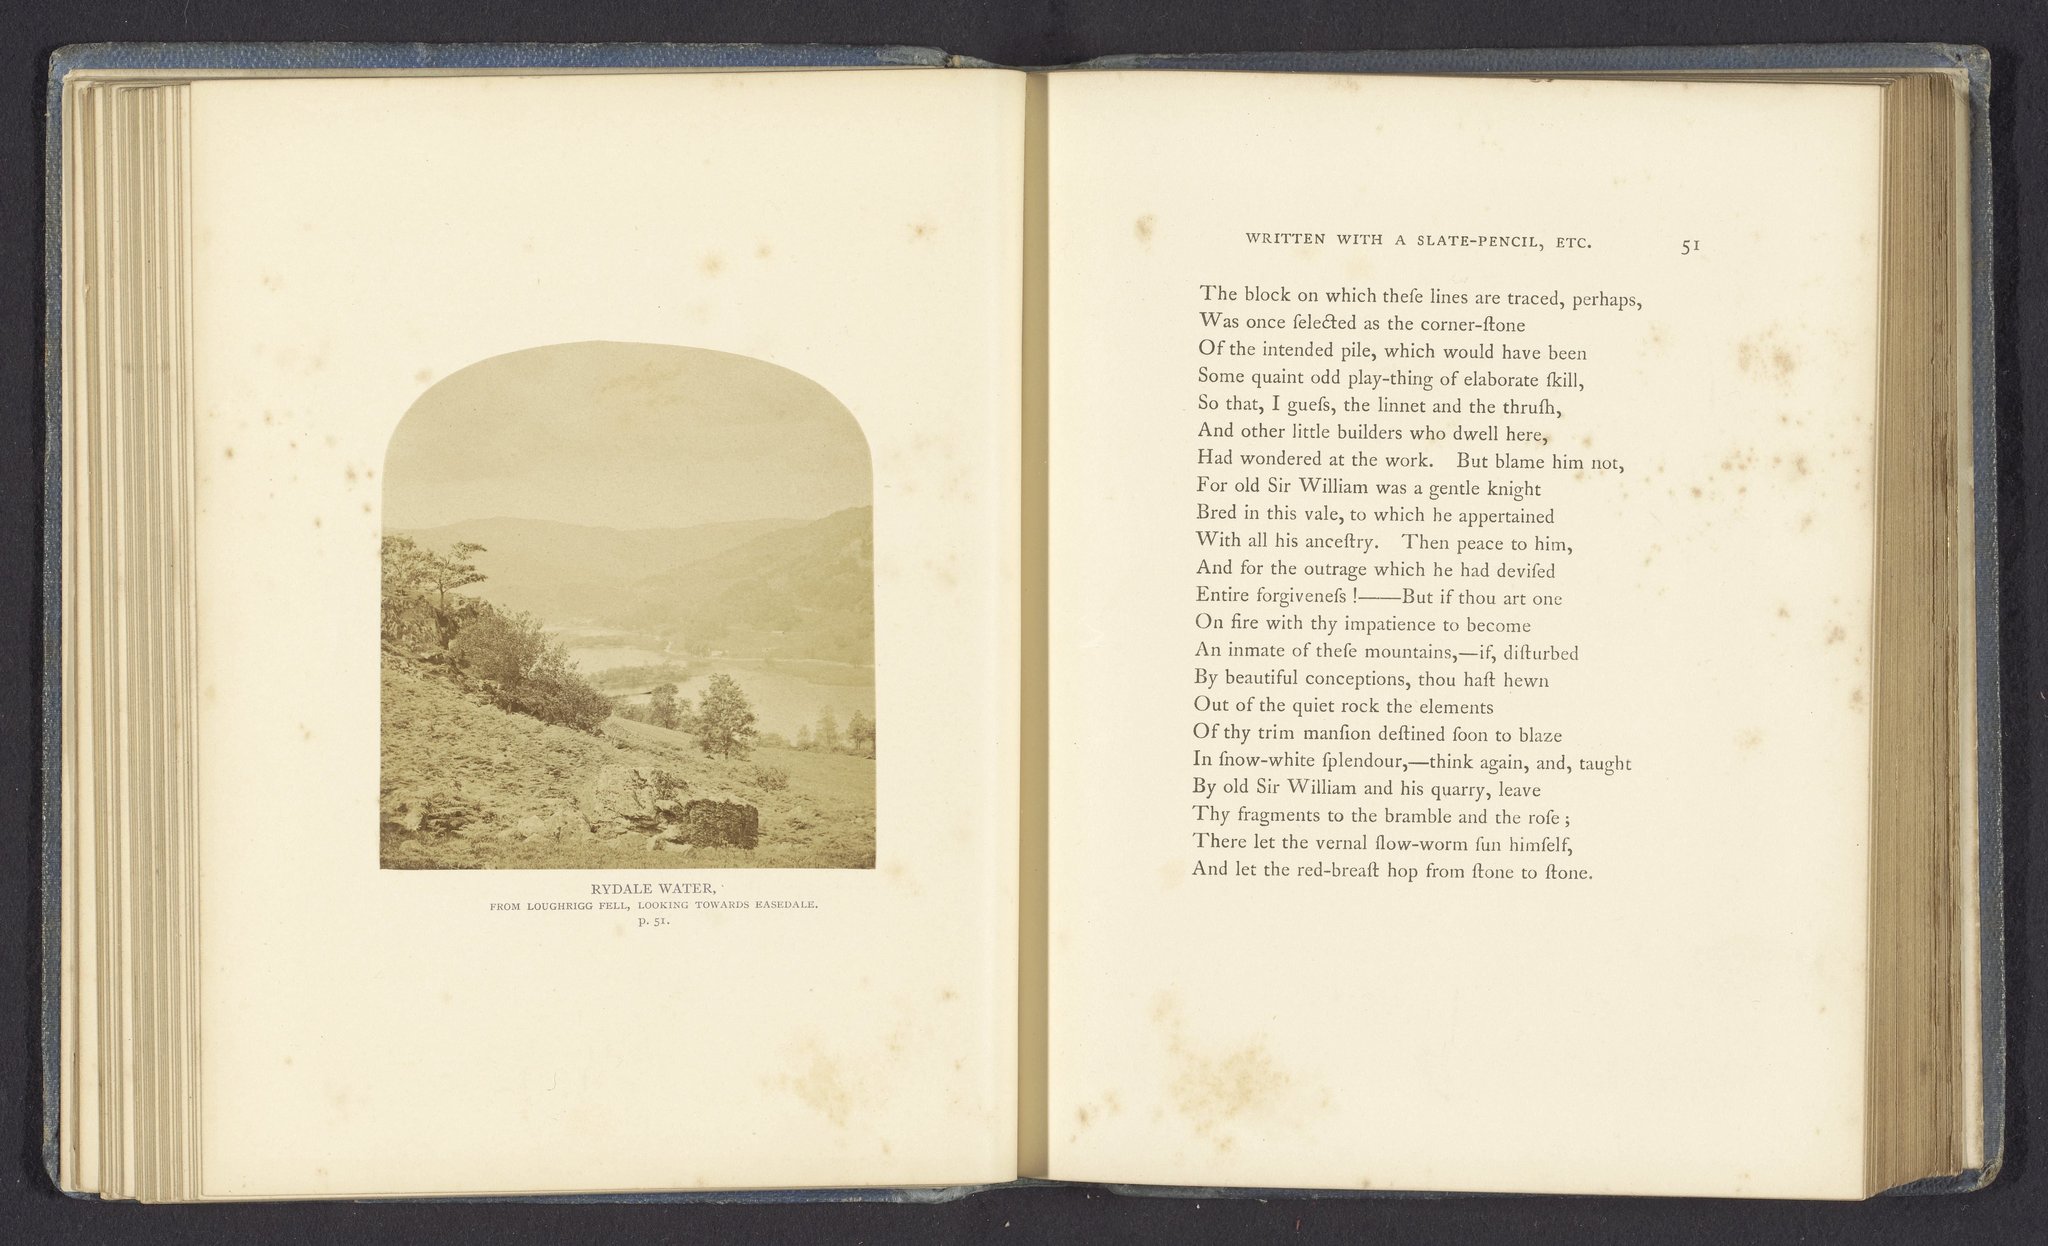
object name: page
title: Rydale Water, from Loughrigg Fell, looking towards Easedale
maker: thomas ogle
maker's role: fotograaf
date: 1854-1864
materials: photographic support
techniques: albumen print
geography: rydal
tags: lake